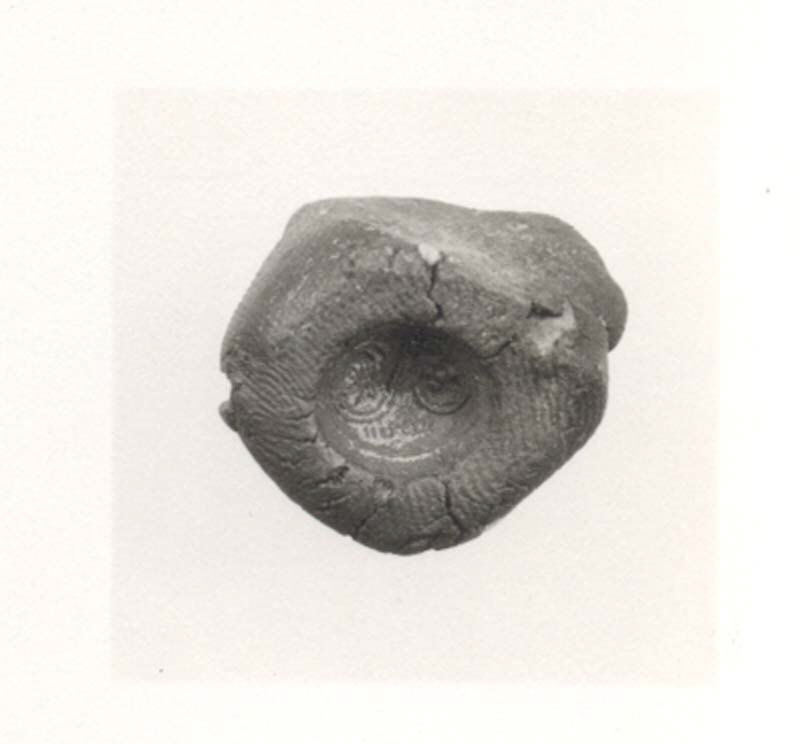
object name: sealing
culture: sasanian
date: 601-700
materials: clay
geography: iran